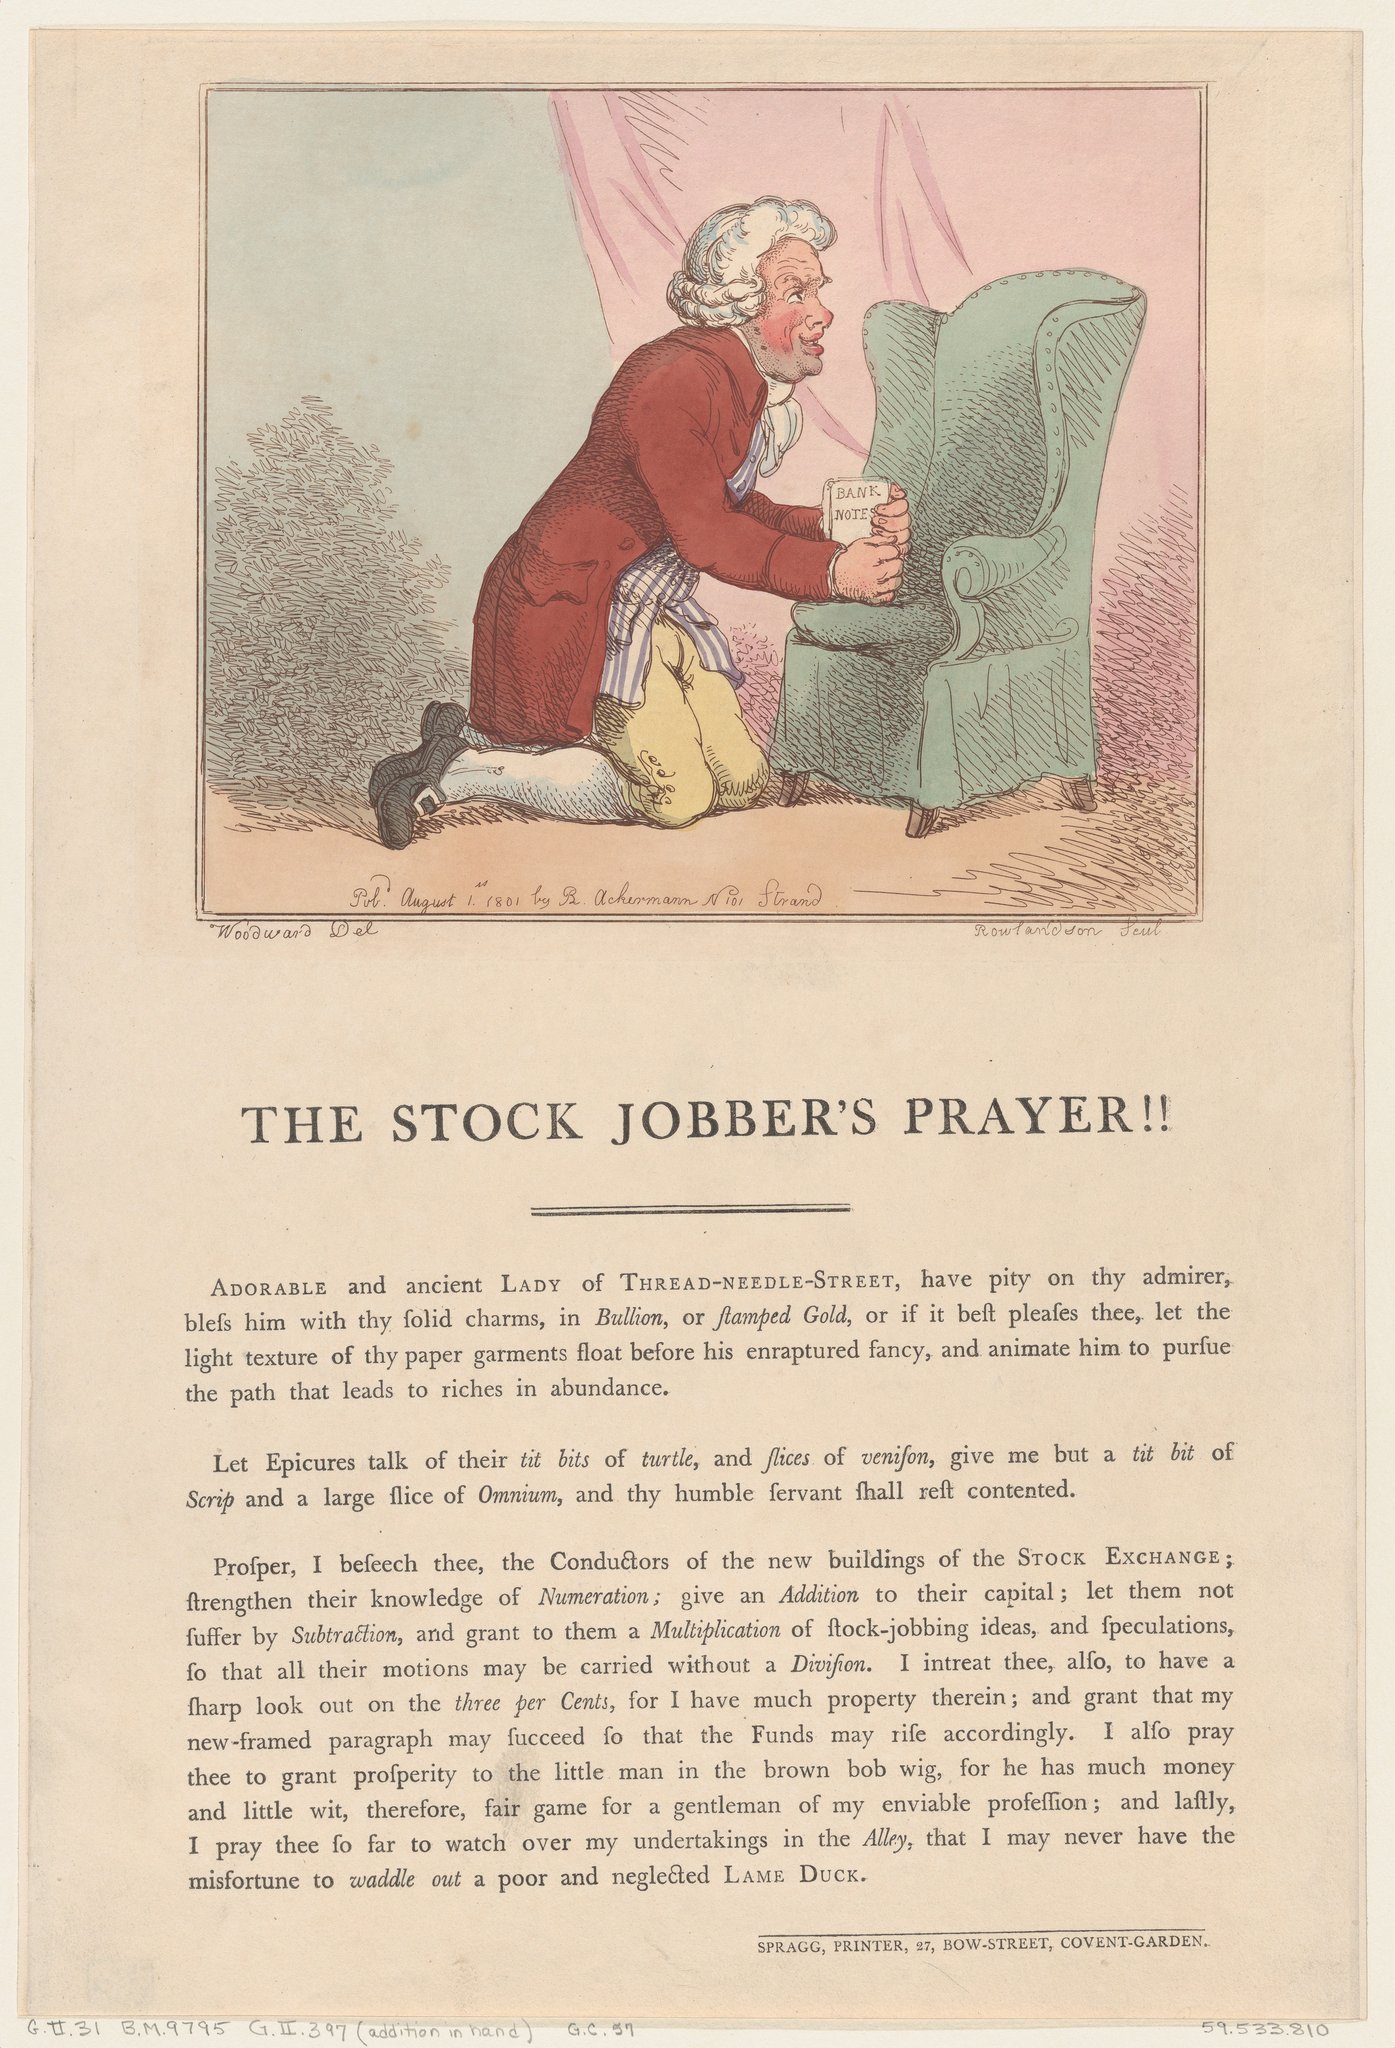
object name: print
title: The Stock Jobber's Prayer!!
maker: thomas rowlandson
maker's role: artist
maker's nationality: british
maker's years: 1757-1827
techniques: etching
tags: men,praying